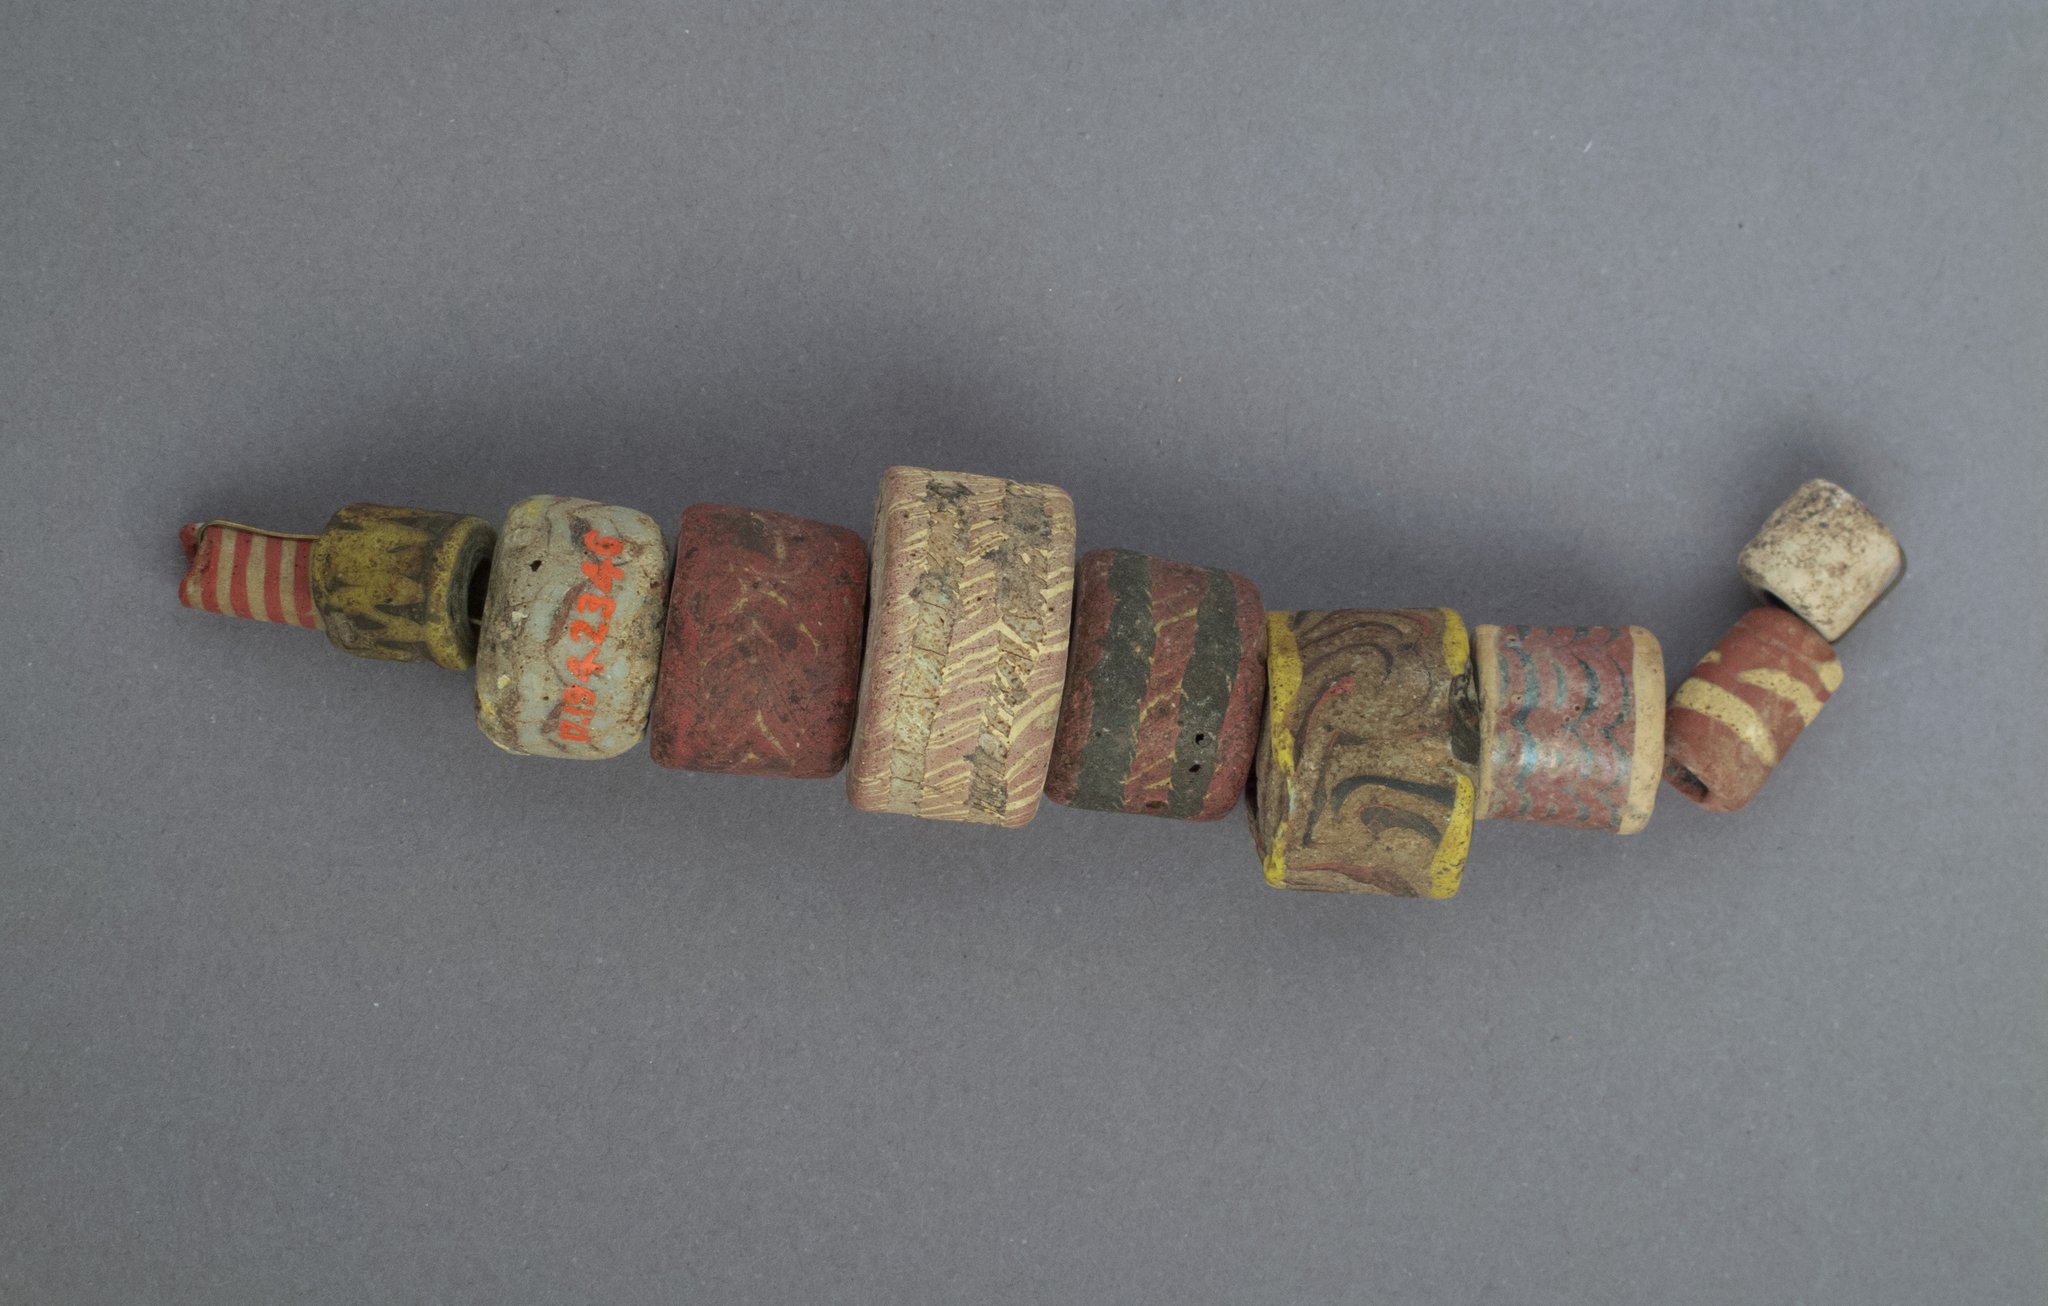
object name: bead, 10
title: Beads, 10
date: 7000 BCE-330 CE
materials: glass